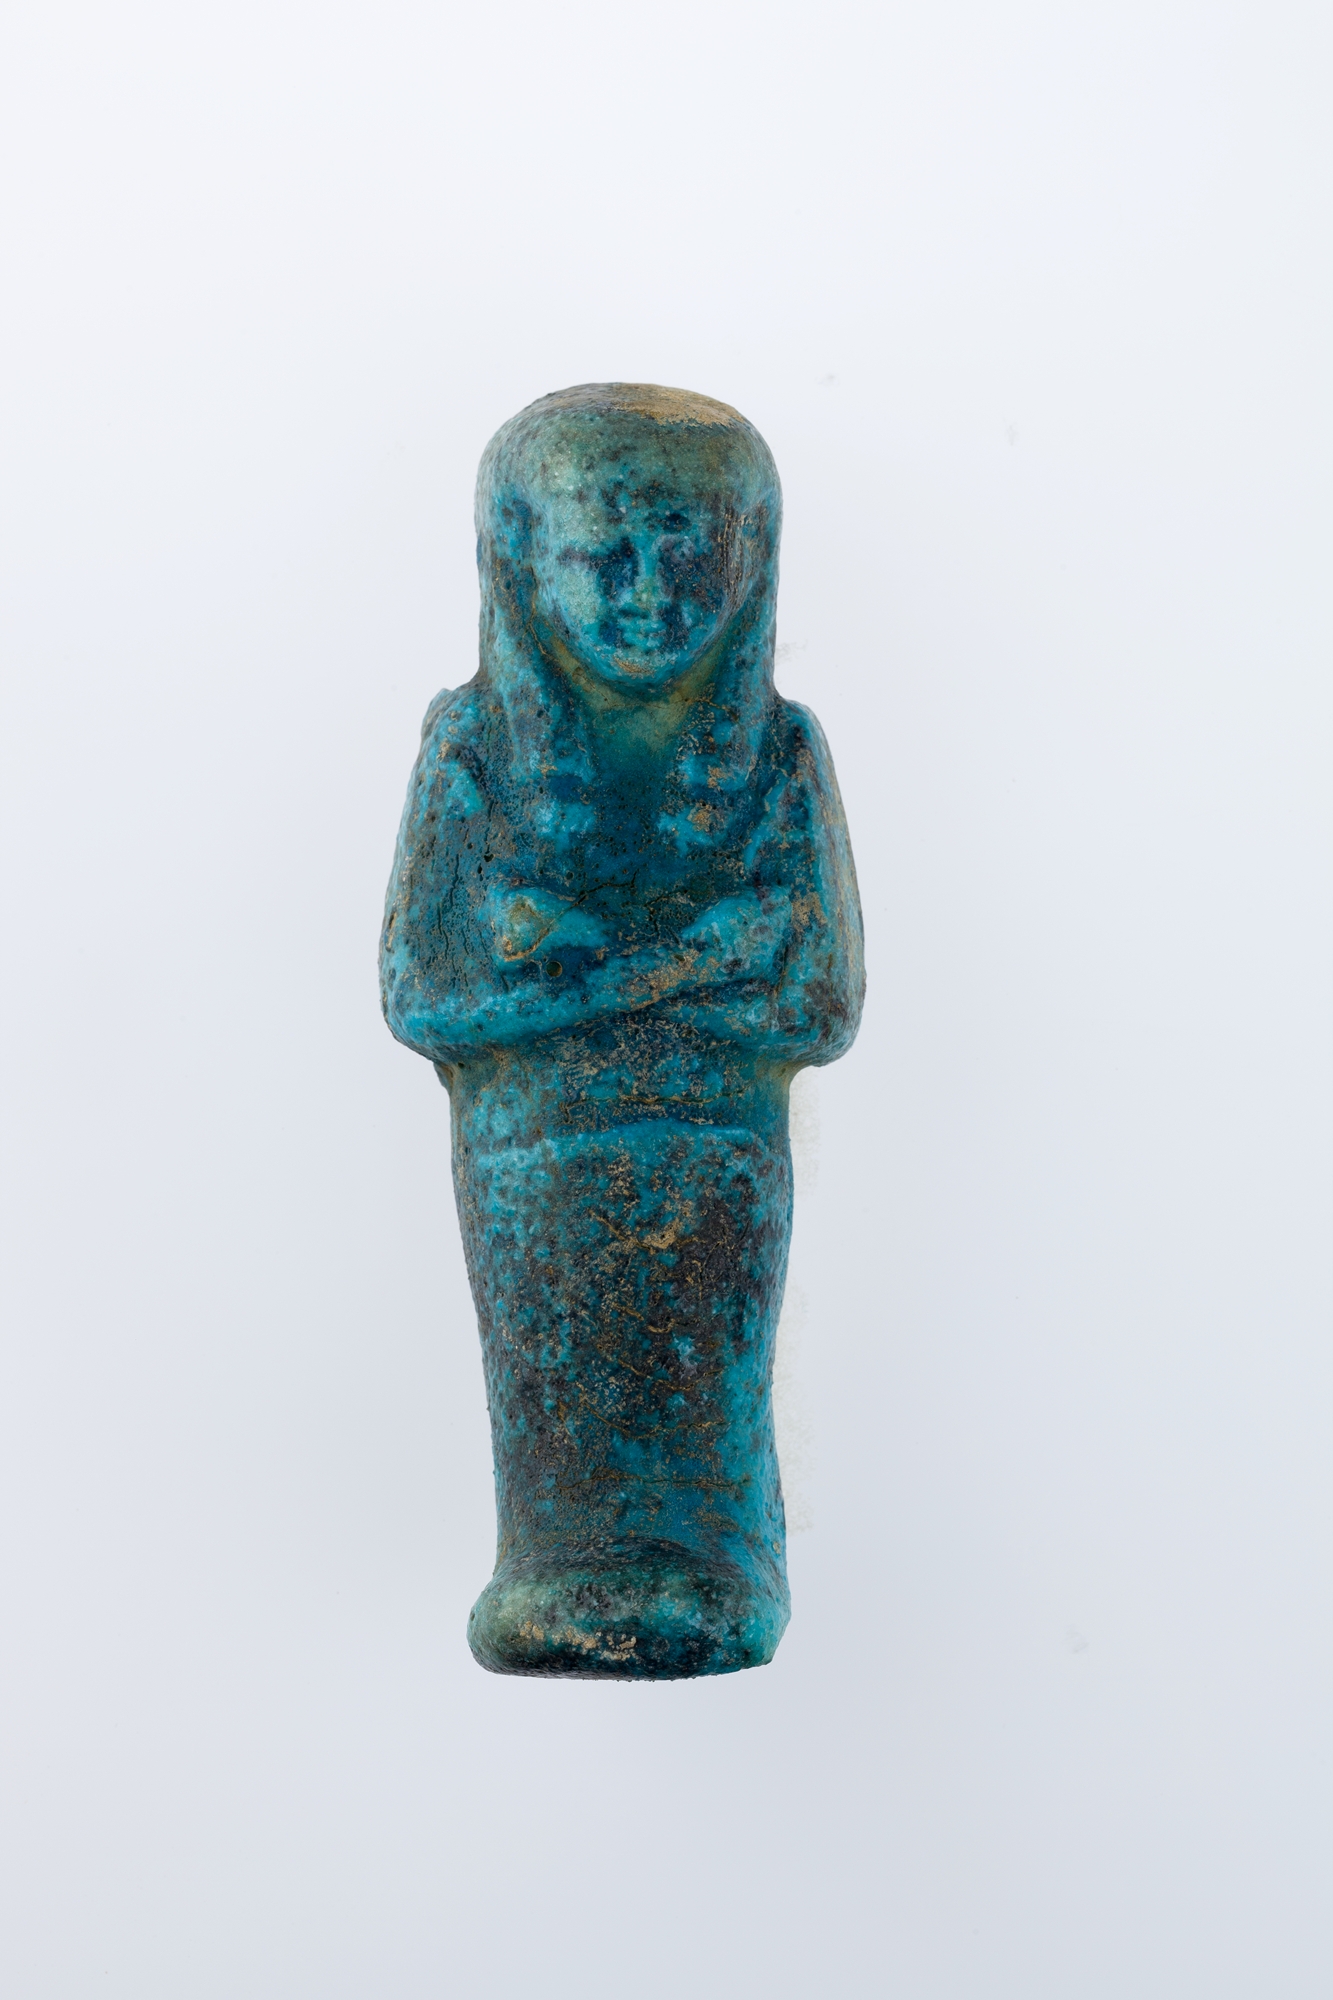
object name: shabti, henettawy c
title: Worker Shabti of Henettawy (C), Daughter of Isetemkheb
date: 990-970 BCE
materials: faience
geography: egypt